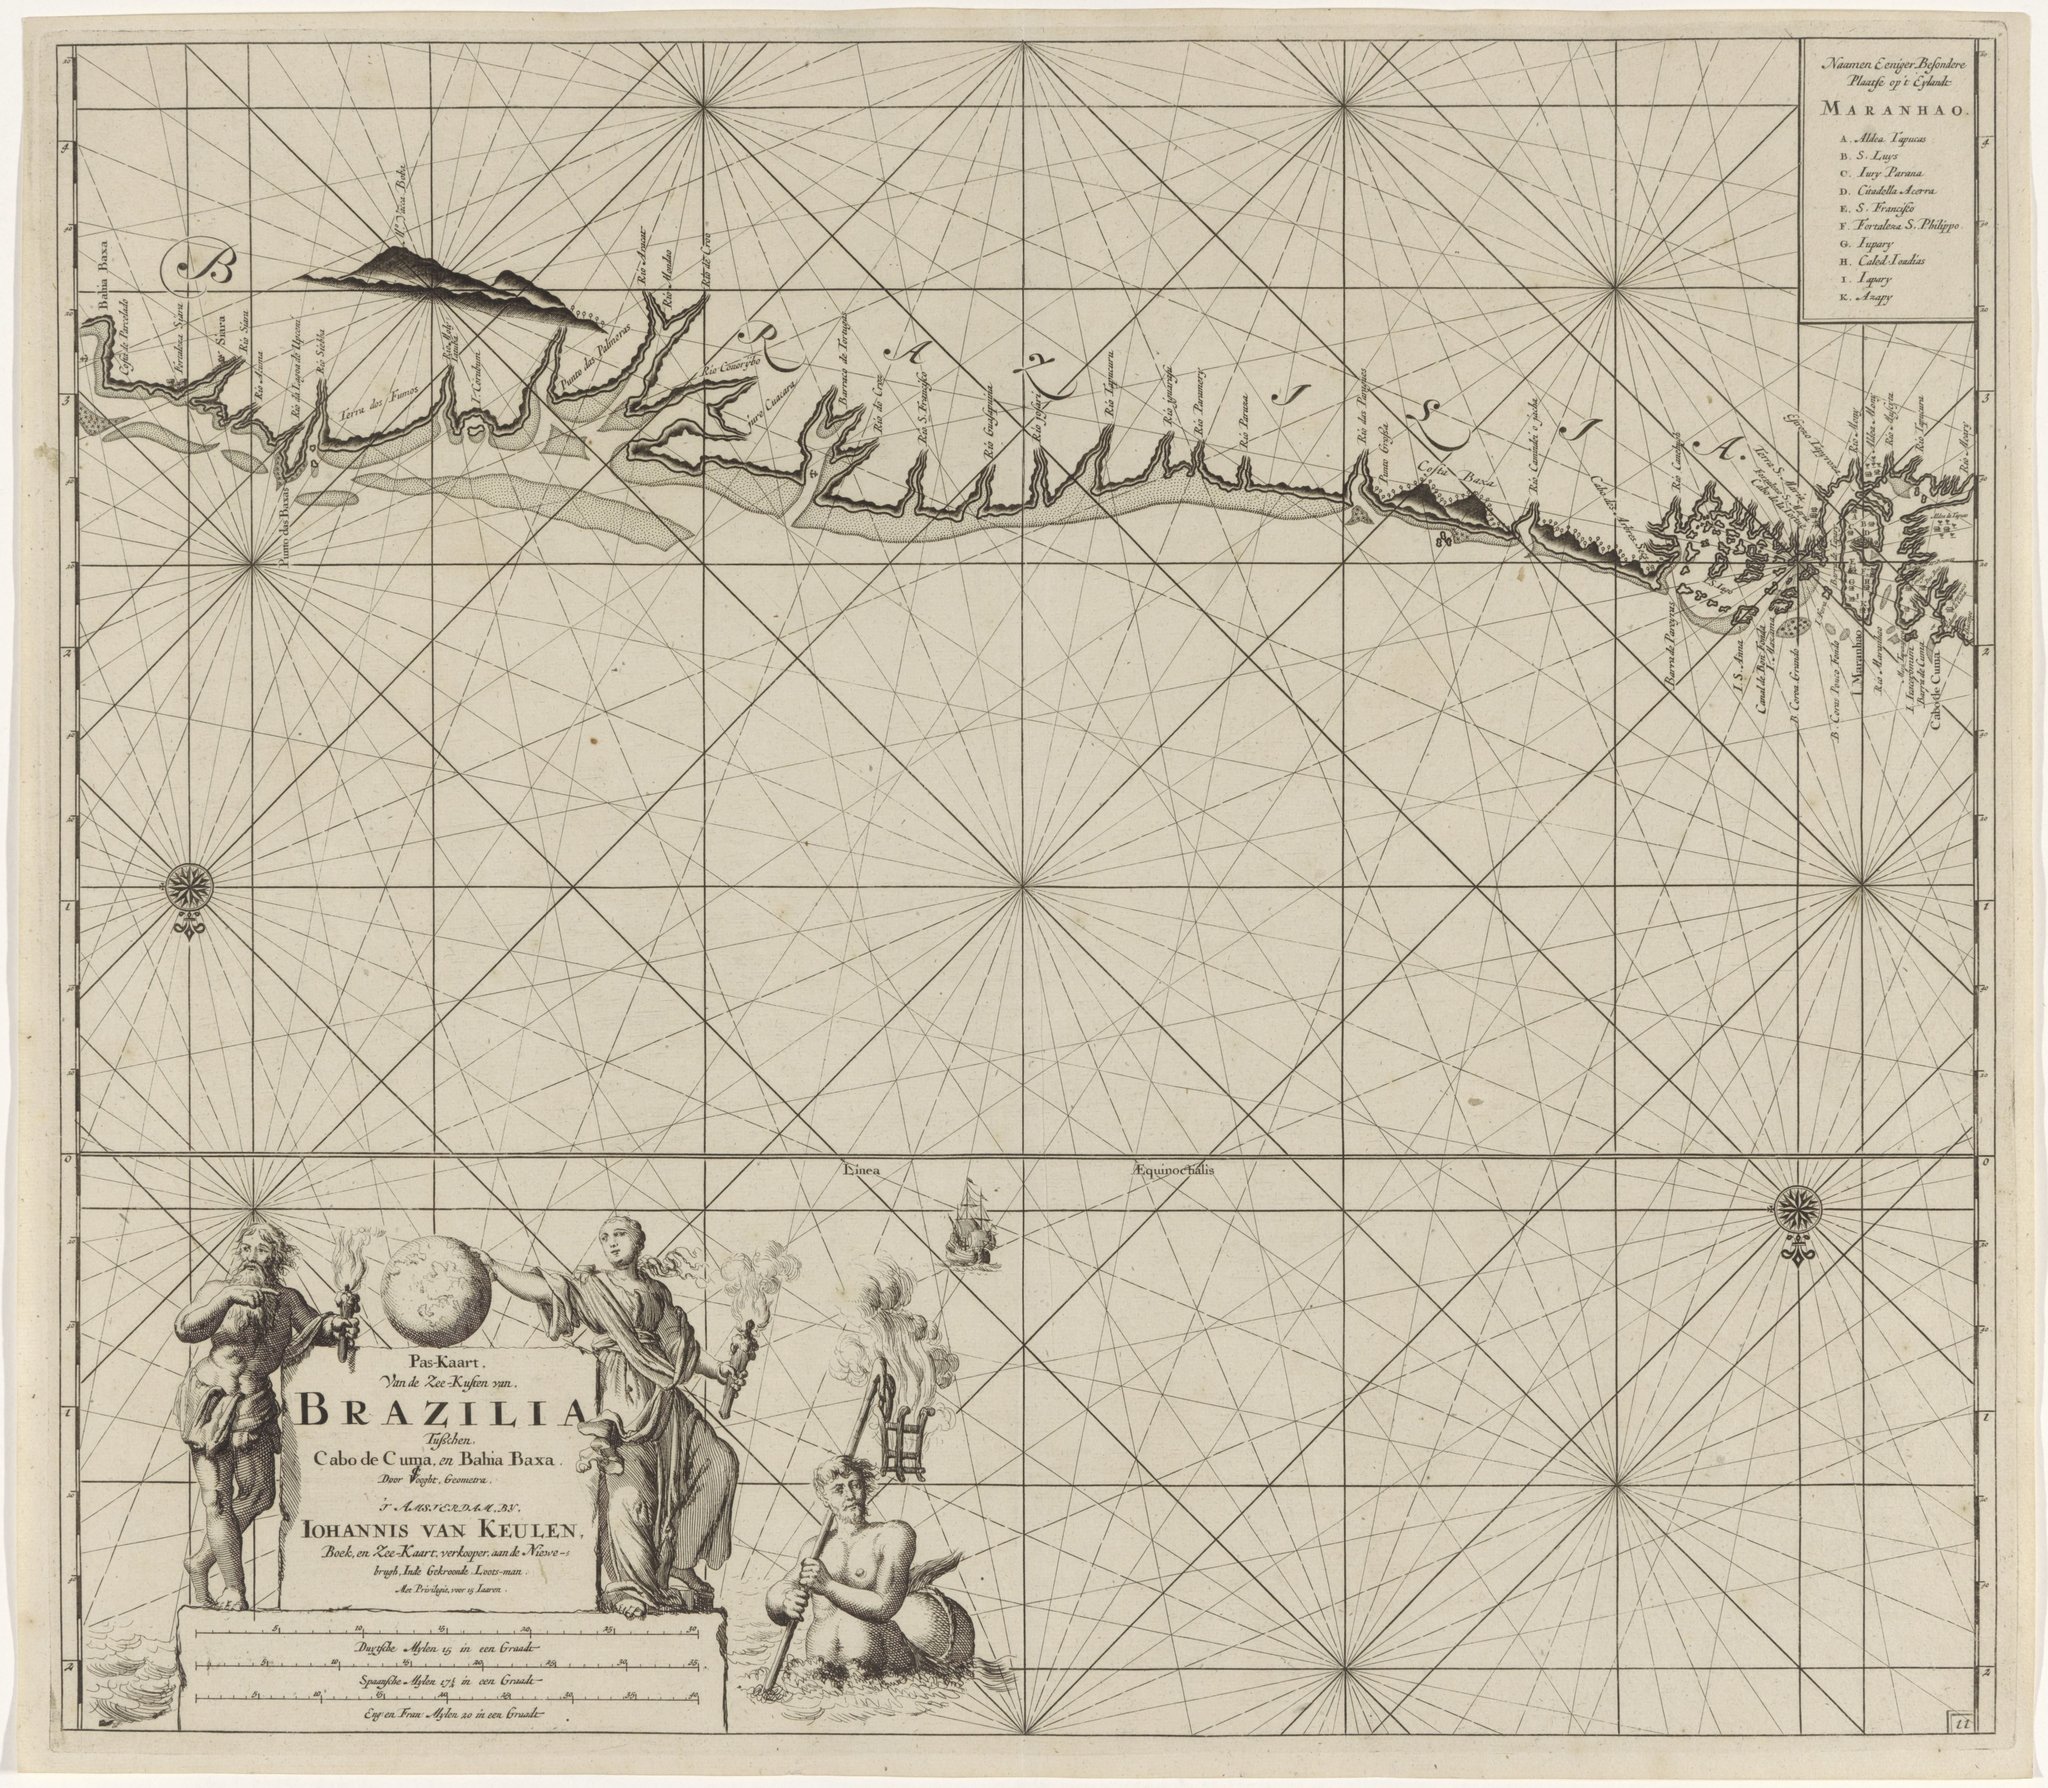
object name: print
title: Pas-kaart, van de zee-kusten van, Brazilia tusschen, Cabo de Cuma, en Bahia Baxa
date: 1683-1799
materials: paper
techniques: engraving, etching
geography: amsterdam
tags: torch, sailing-ship, sailing-boat, merman, globe, brasil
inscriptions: collector's mark: Lugt 2228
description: Paskaart van de noordoostkust van Brazilië, met twee kompasrozen, het Noorder ligt onder. Linksonder de titel, het adres van de uitgever en de schaalverdeling, welke is weergegeven in Duitse, Spaanse en Engelse of Franse mijlen (schaal: c. 1:1.500.000). De gegevens zijn geflankeerd door een man met een toorts en een vrouw met een globe en een toorts, naast haar een watergod.